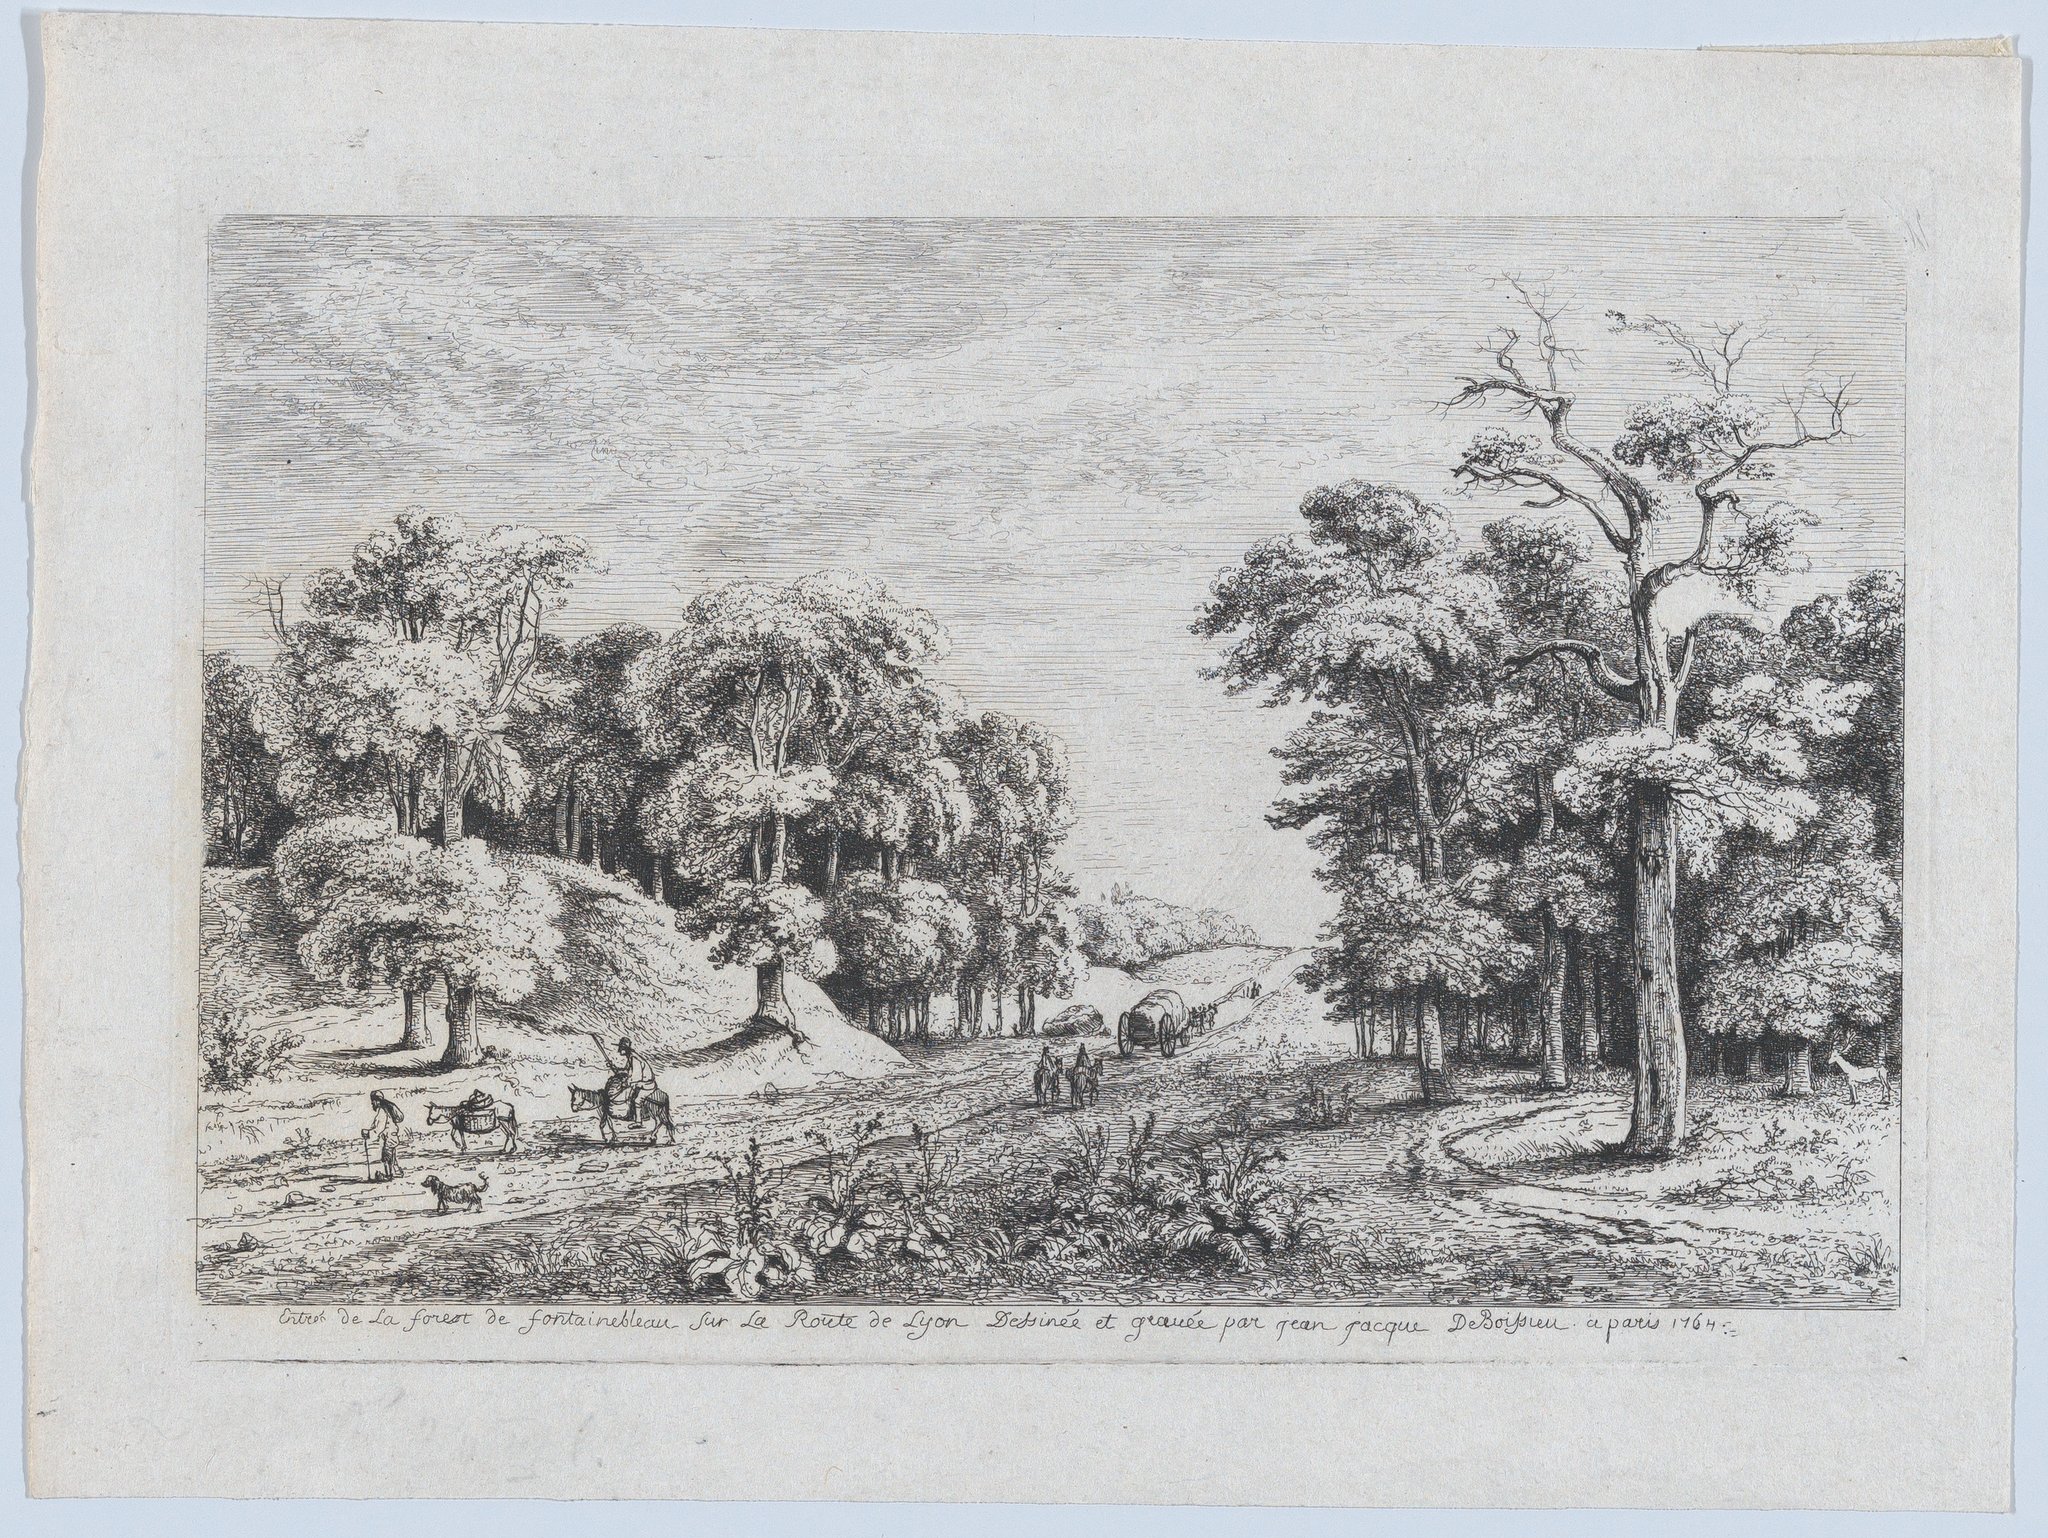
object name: print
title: Entrance to the Forest of Fontainebleau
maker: jean jacques de boissieu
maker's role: artist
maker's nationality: french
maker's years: 1736-1810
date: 1764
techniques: drypoint, etching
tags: men,dogs,horses,forests,carriages